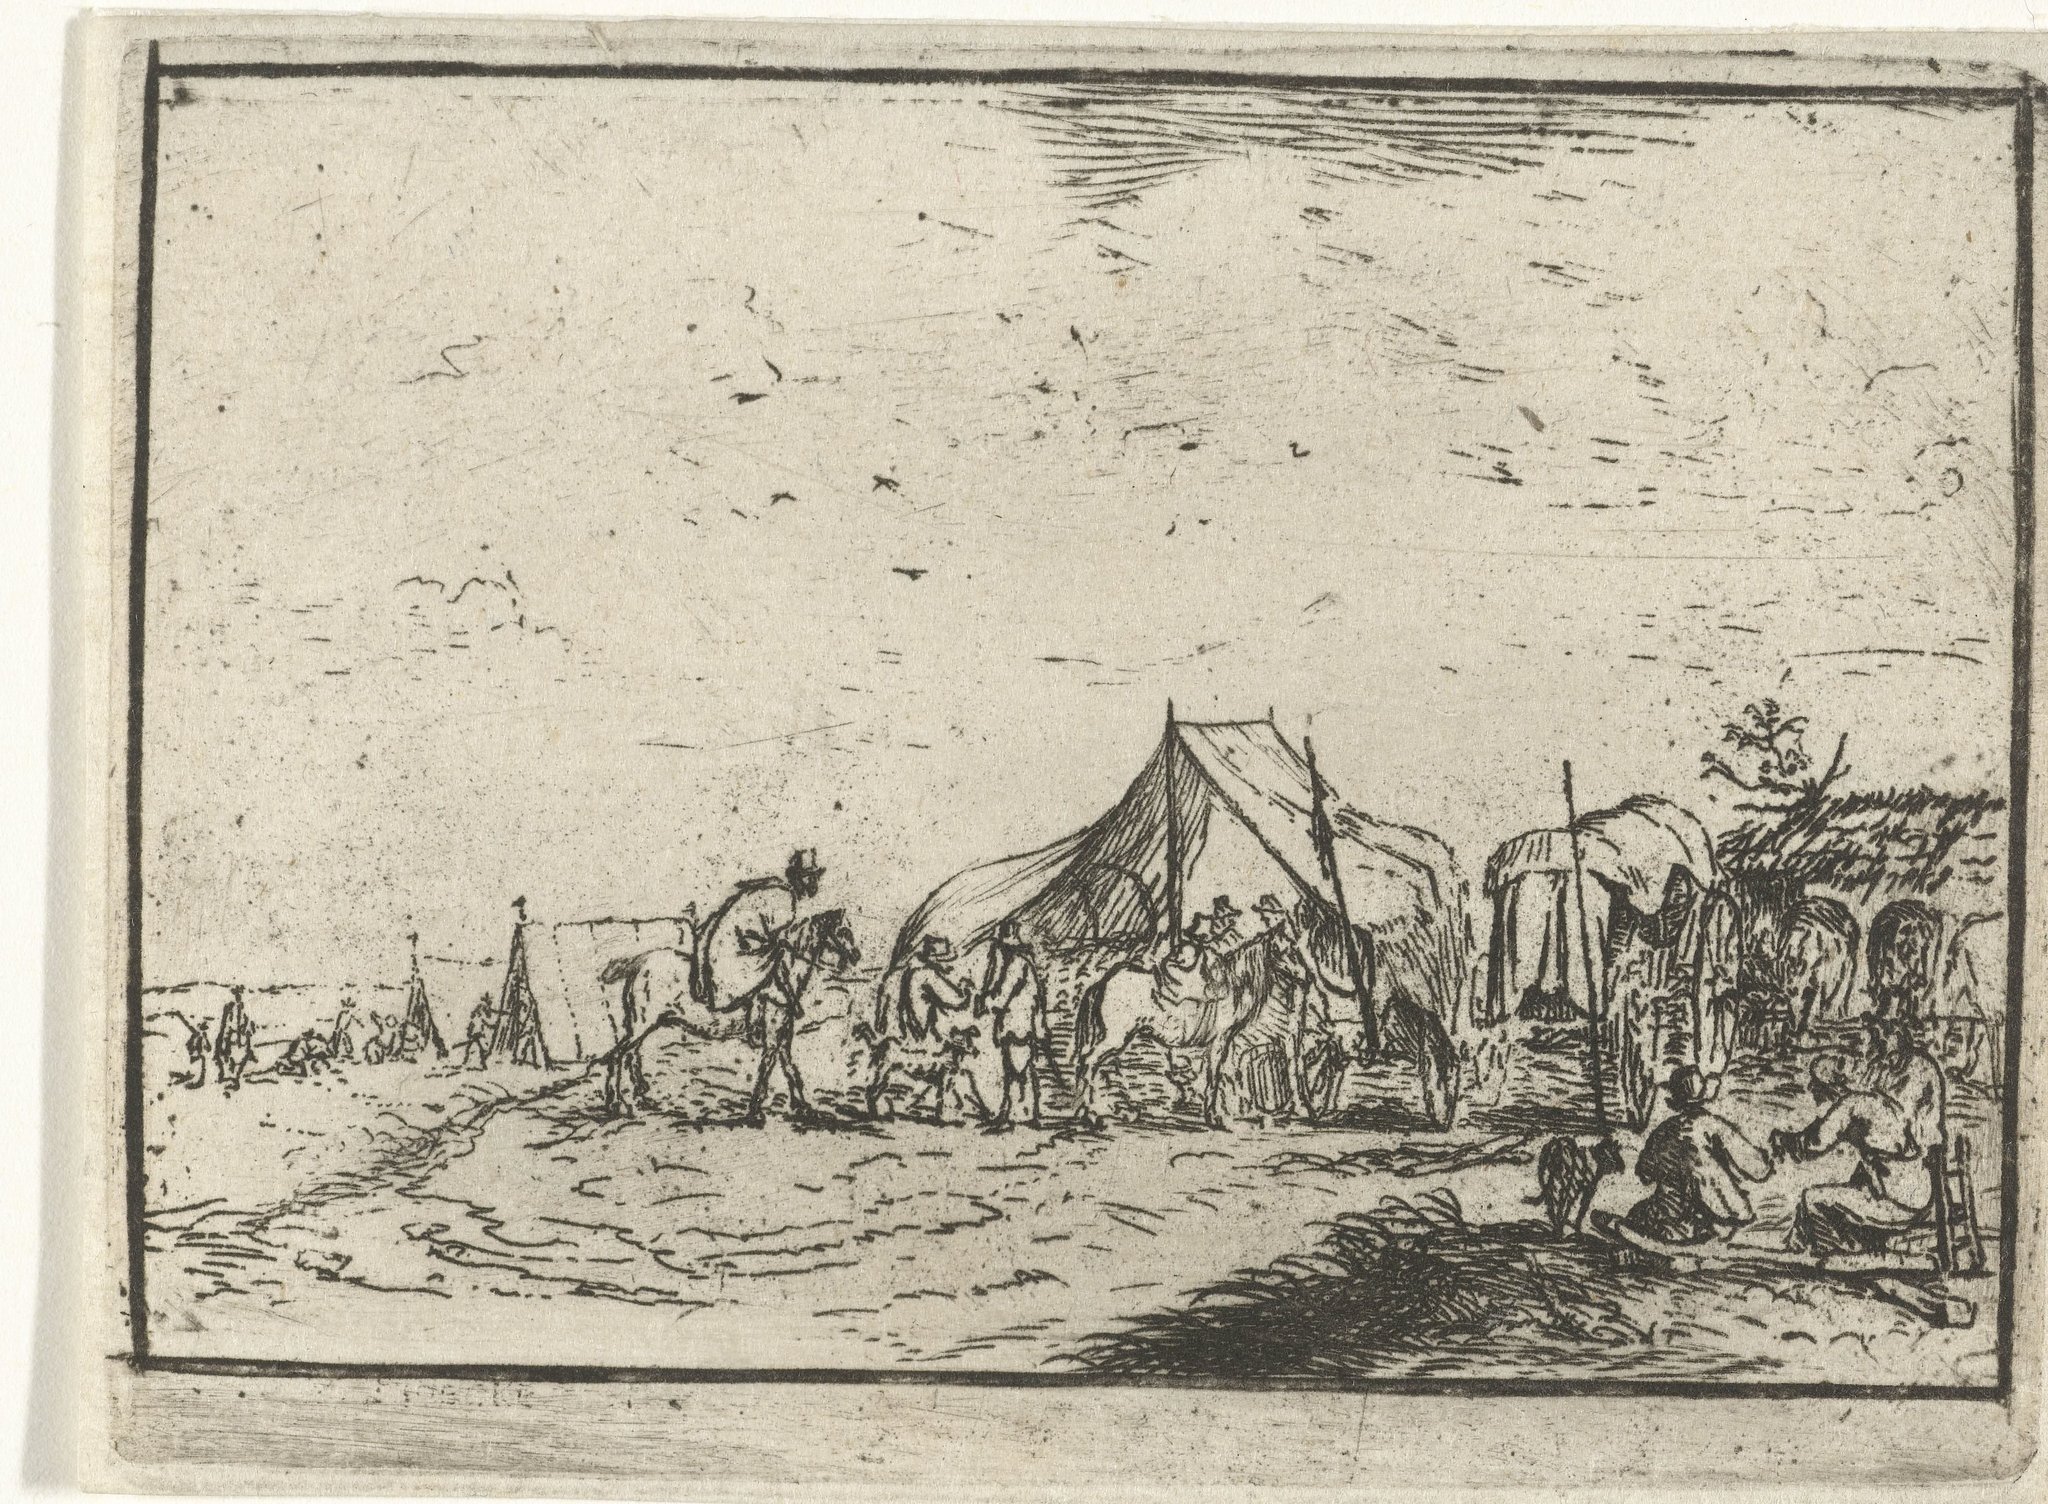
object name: print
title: Landschappen met kampementen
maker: robert van den hoecke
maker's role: draughtsman, painter, print maker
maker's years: 1622-1668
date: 1632-1668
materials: paper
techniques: etching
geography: southern netherlands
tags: tent-camp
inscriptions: collector's mark: Lugt 240